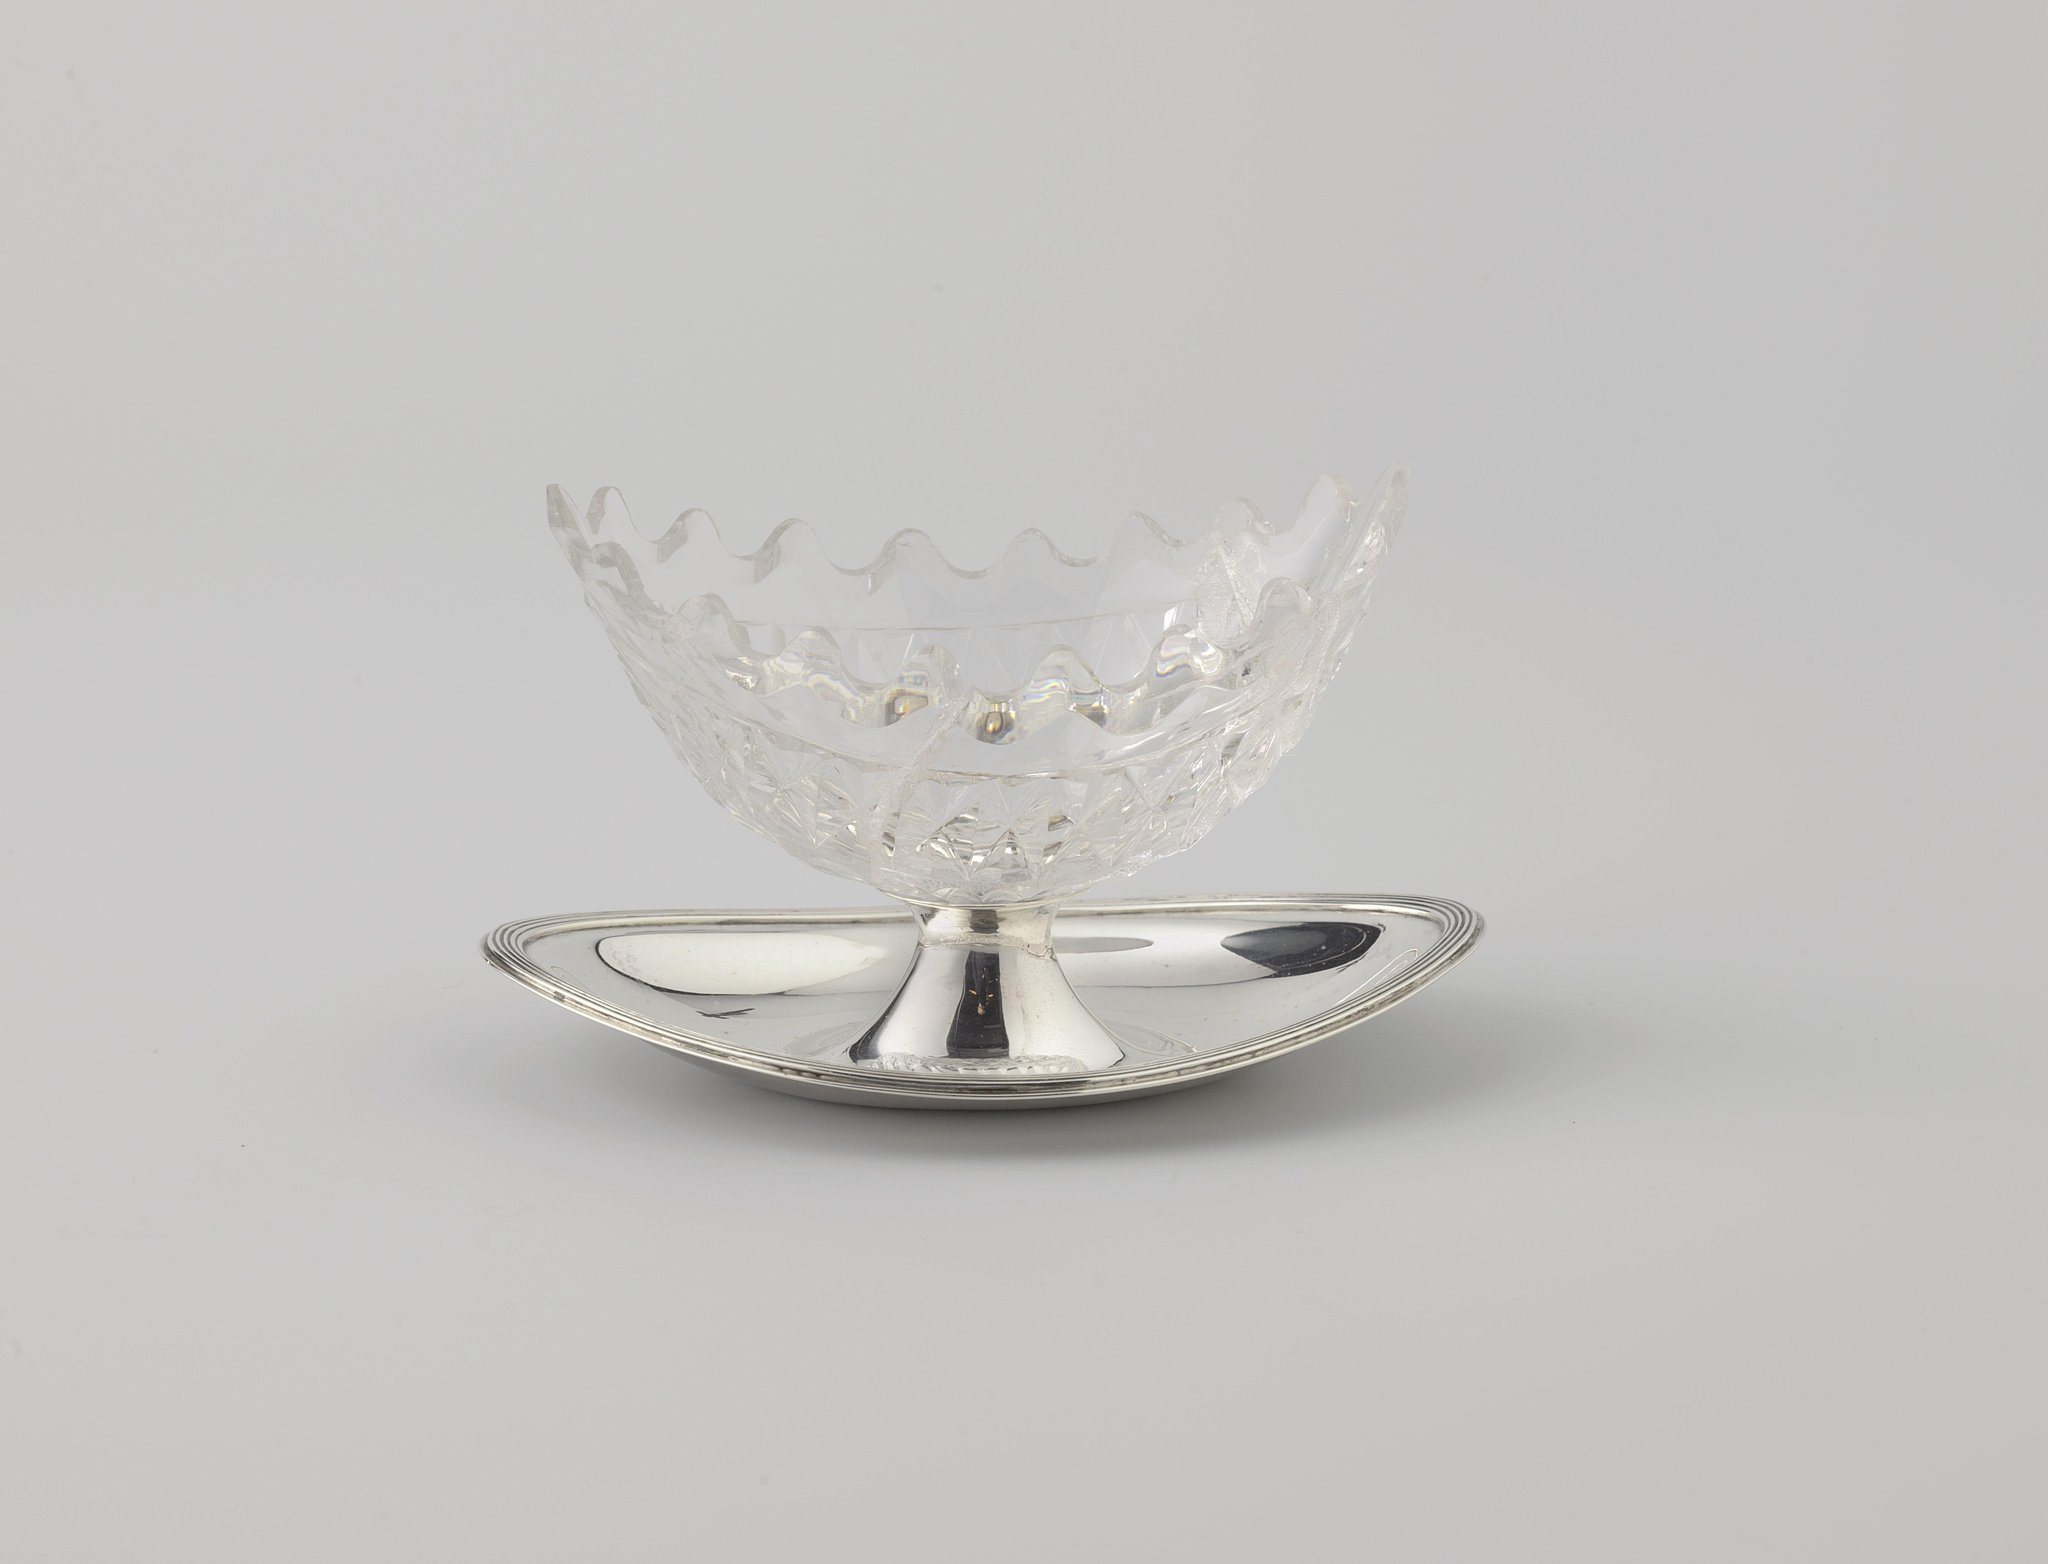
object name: salt condiment vessel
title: Zoutvat op ovale voet met spitsovale glazen bak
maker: diederik lodewijk bennewitz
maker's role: silversmith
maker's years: 1763-1826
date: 1807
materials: glass, gold, silver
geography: amsterdam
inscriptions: alloy mark: ‘Hollandse leeuw’, town mark: ‘Amsterdam’, maker's mark, date letter: ‘Y’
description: De zoutvaten bestaan elk uit een schaalvormige ovale voet, die in het midden oprijst naar het spitsovale bakje. Beide onderdelen lopen aan de zijkanten hoger op. Aan de bovenzijde van de voet is langs de buitenrand een filetrand aangebracht. Het bakje van kleurloos glasheeft een gegolfde bovenrand en is geslepen met een rand van diamantkoppen boven een stralenkrans. Het bakje is aan de voet bevestigd door middel van een zilveren schroef met een gouden kopje, dat aan de binnenzijde van het bakje zichtbaar is. De bakjes van A, B en D zijn beschadigd.